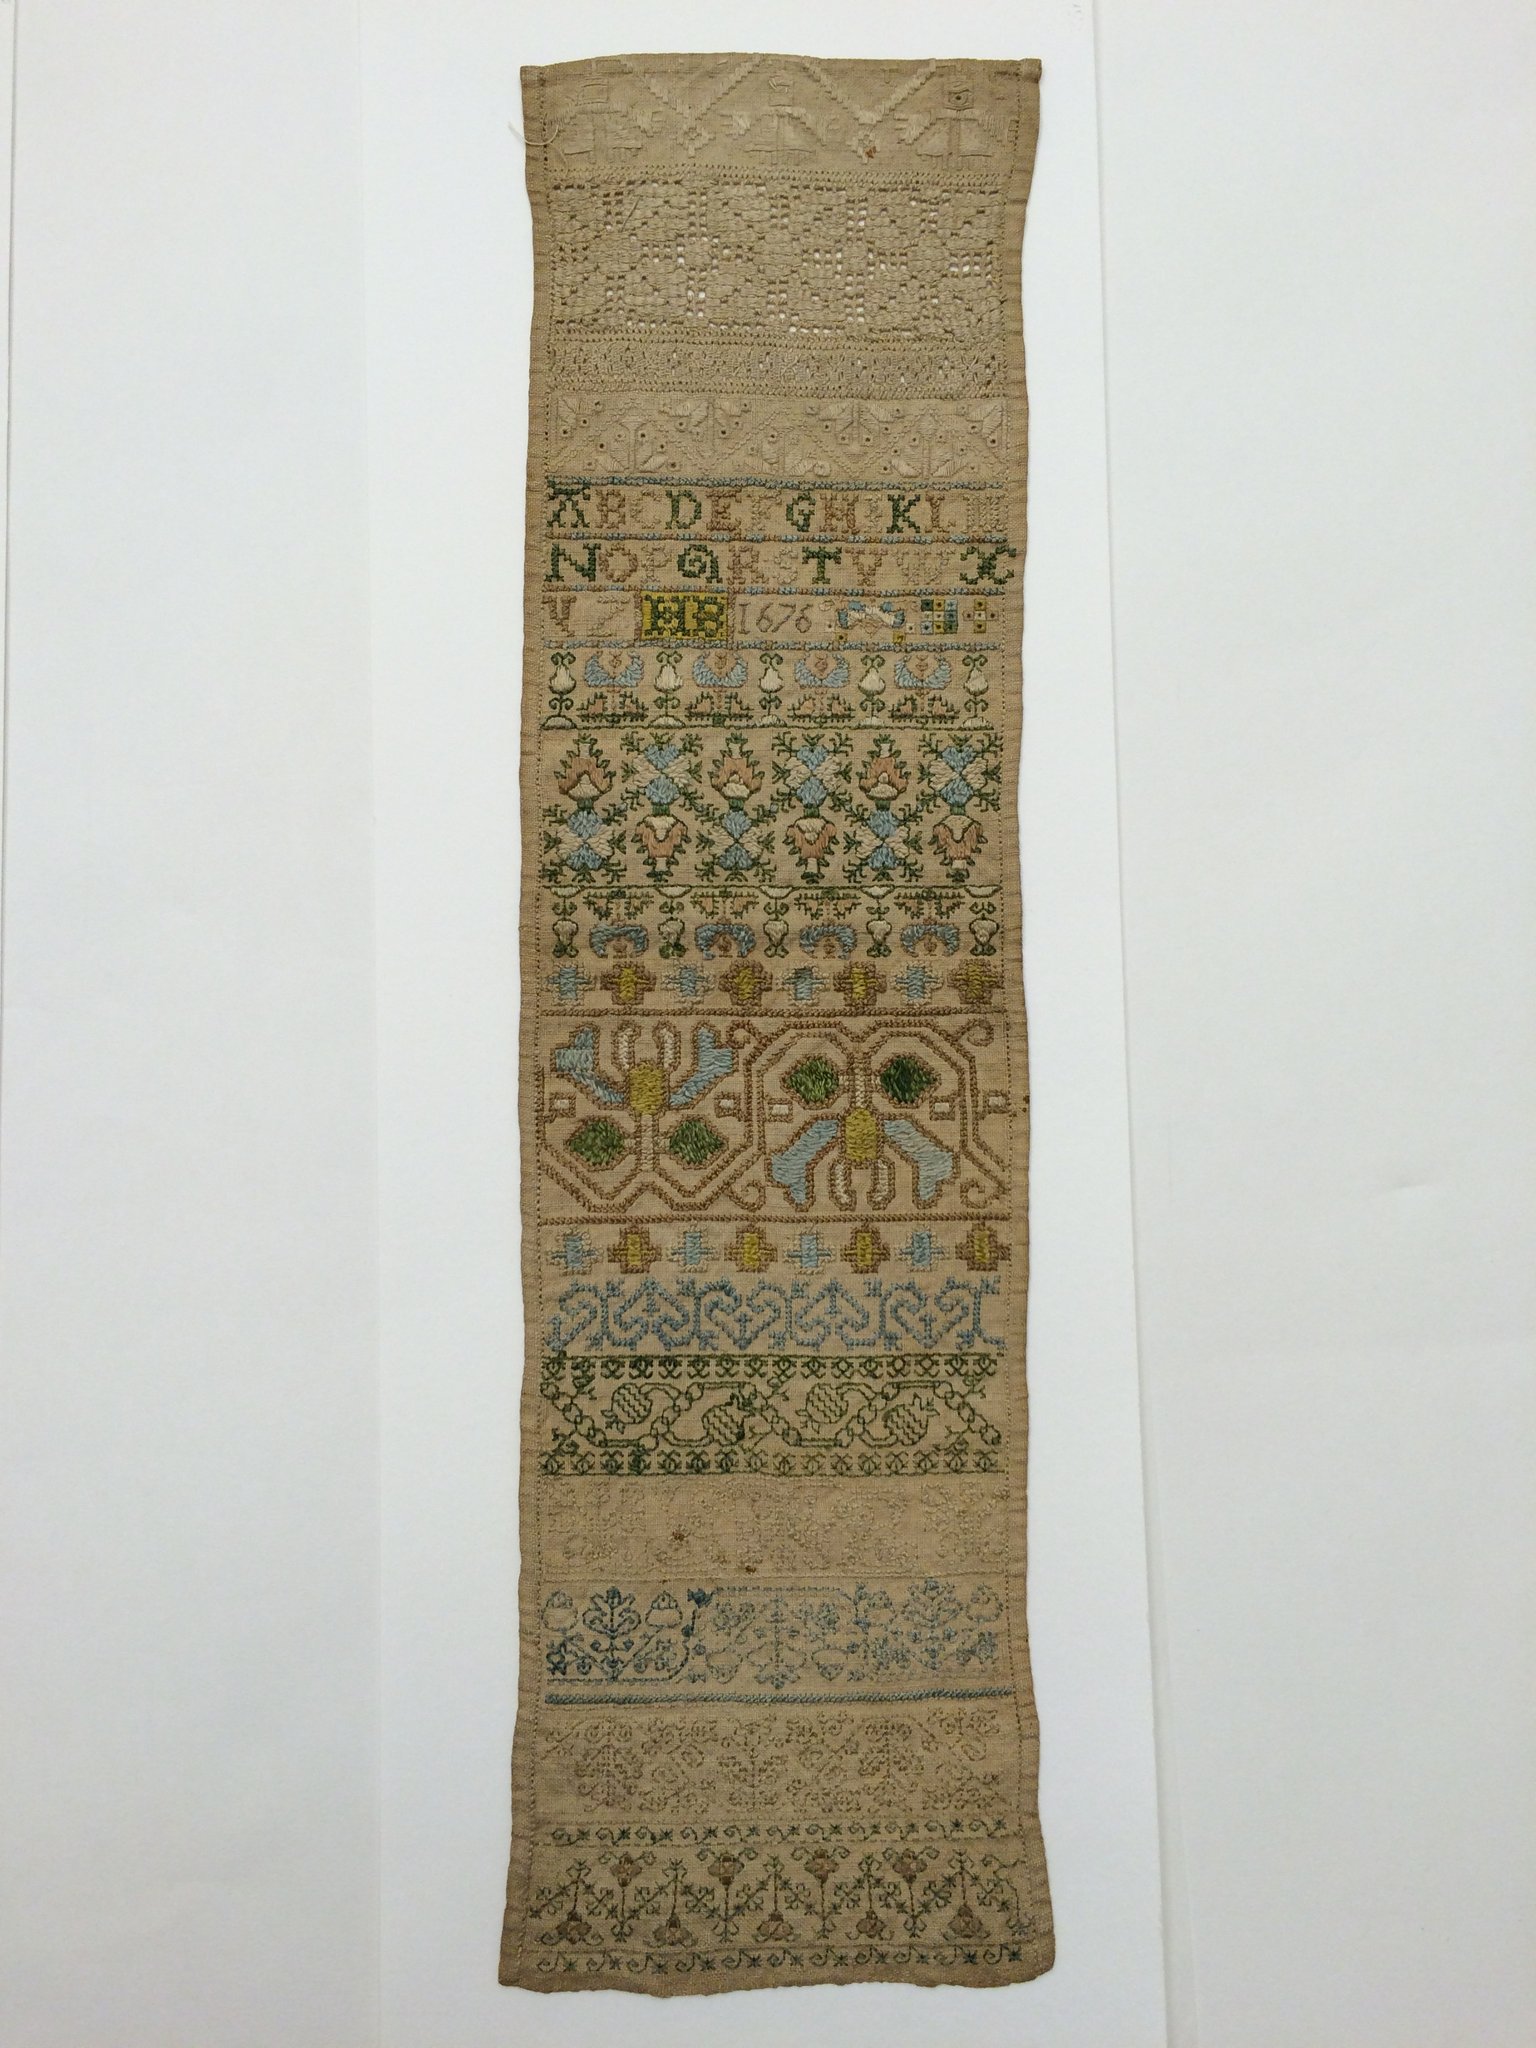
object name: sampler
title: Embroidered band sampler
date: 1676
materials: linen, silk